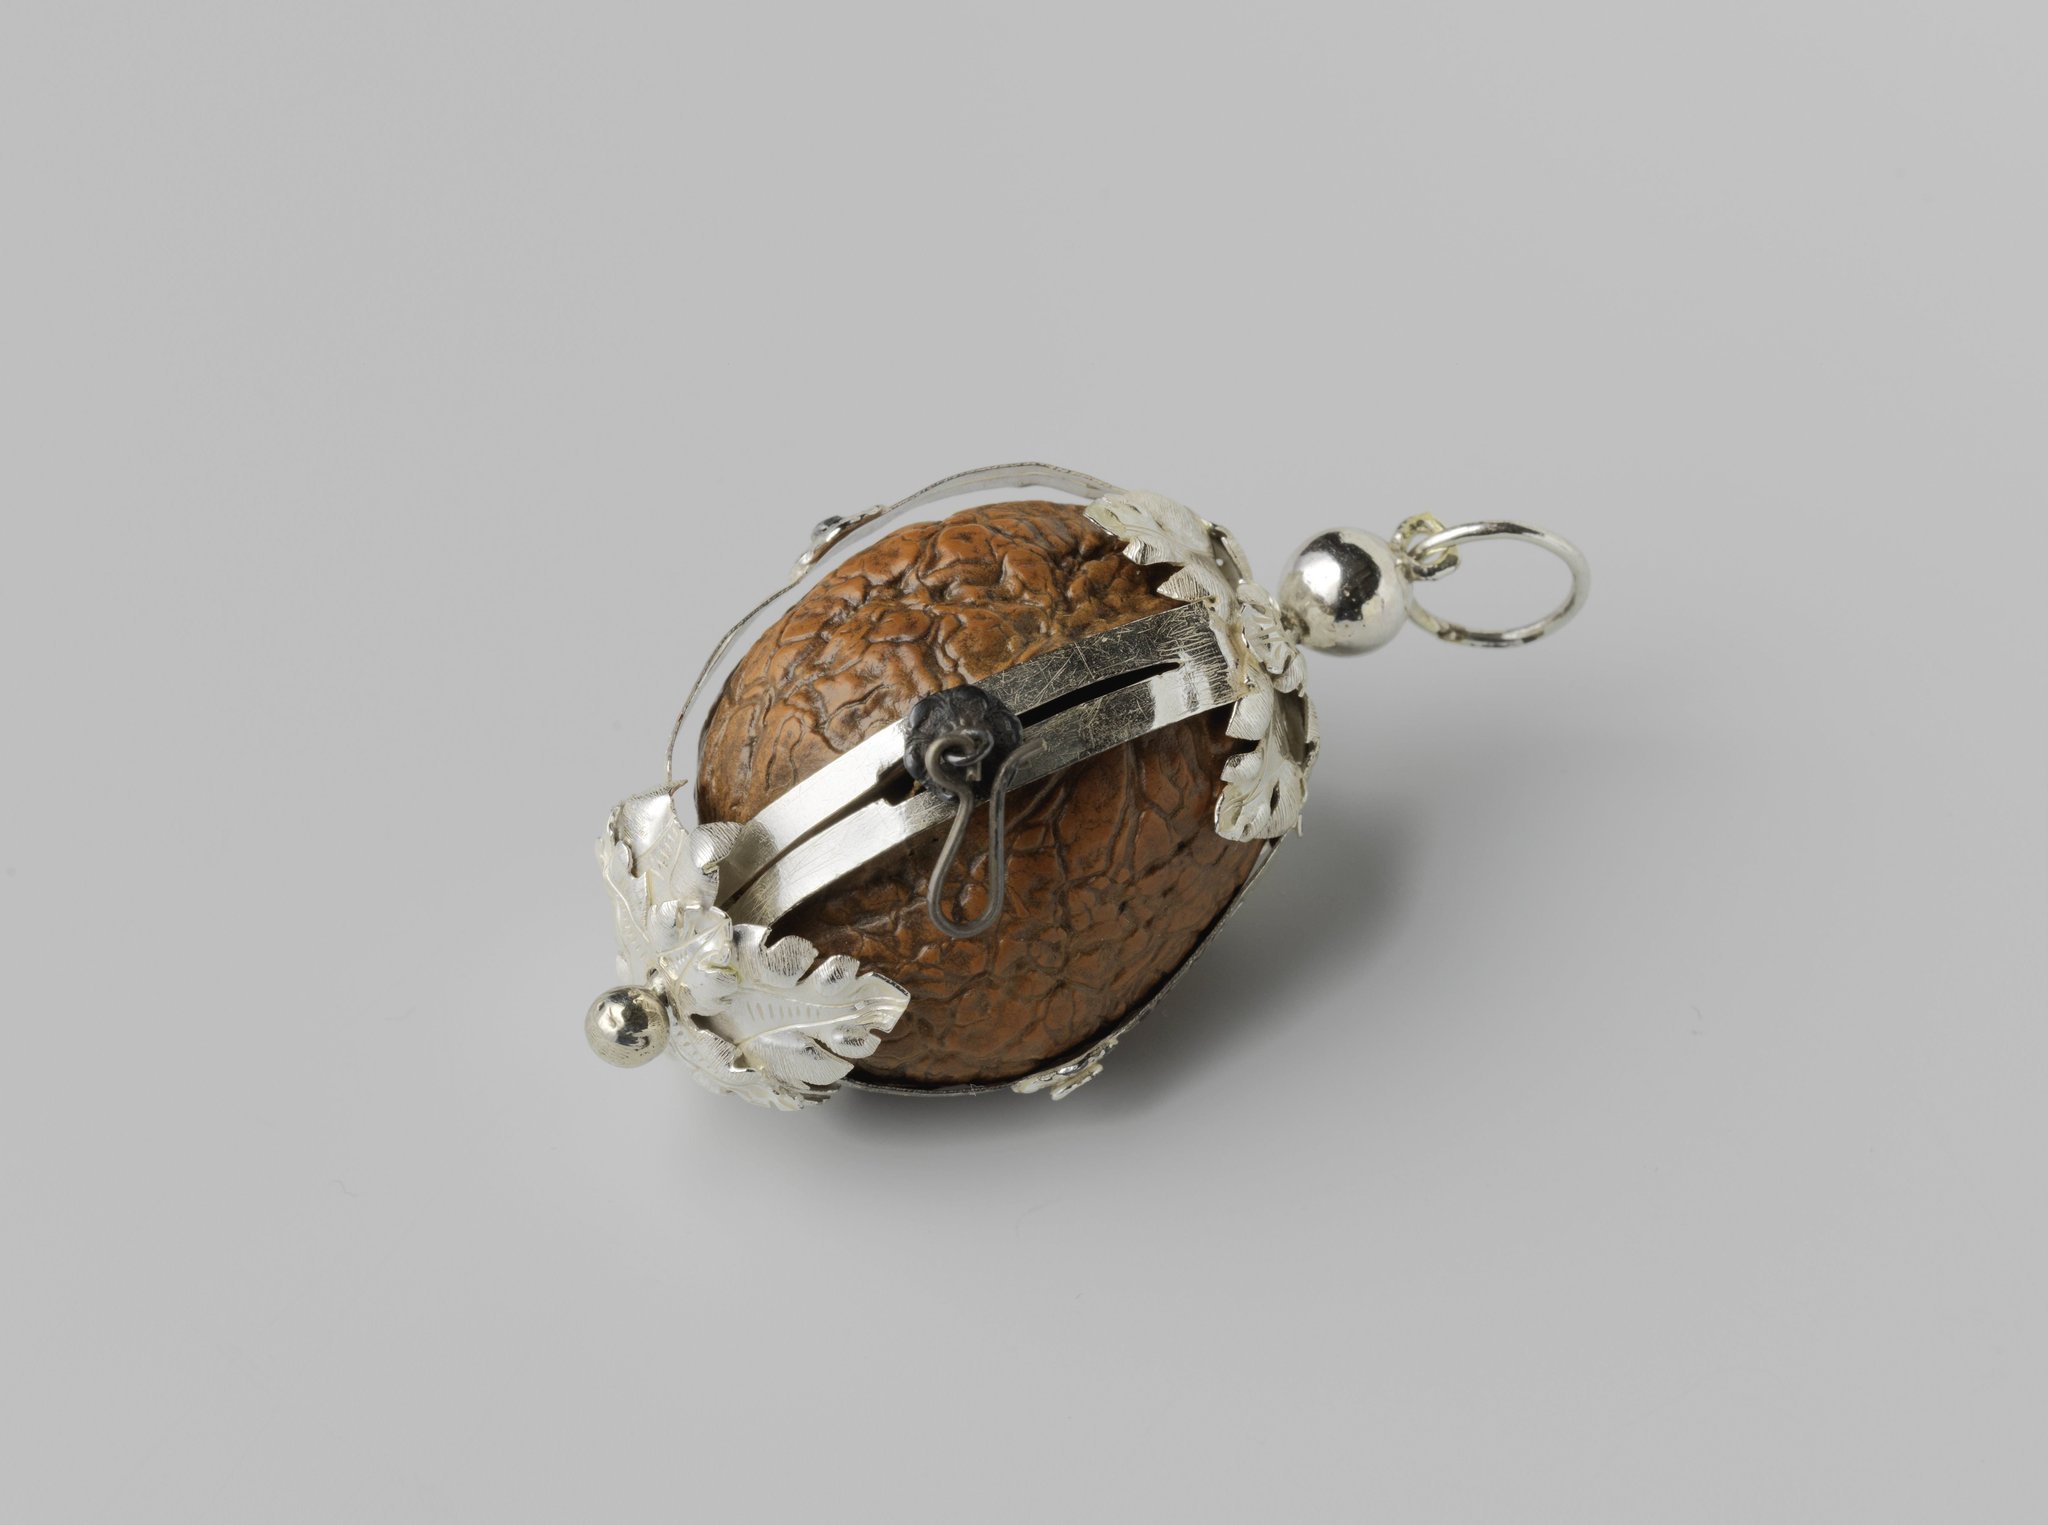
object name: prayer nut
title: Gebedsnoot, gevat in banden van zilver met bladrozetten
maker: Anonymous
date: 1500-1549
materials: nut, silver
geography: northern netherlands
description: Gebedsnoot, gevat in banden van zilver met bladrozetten. Door de hoofdas loopt een draaiende spil, waaromheen een perkamenten blad is gewikkeld, beschreven met de Tien Geboden.